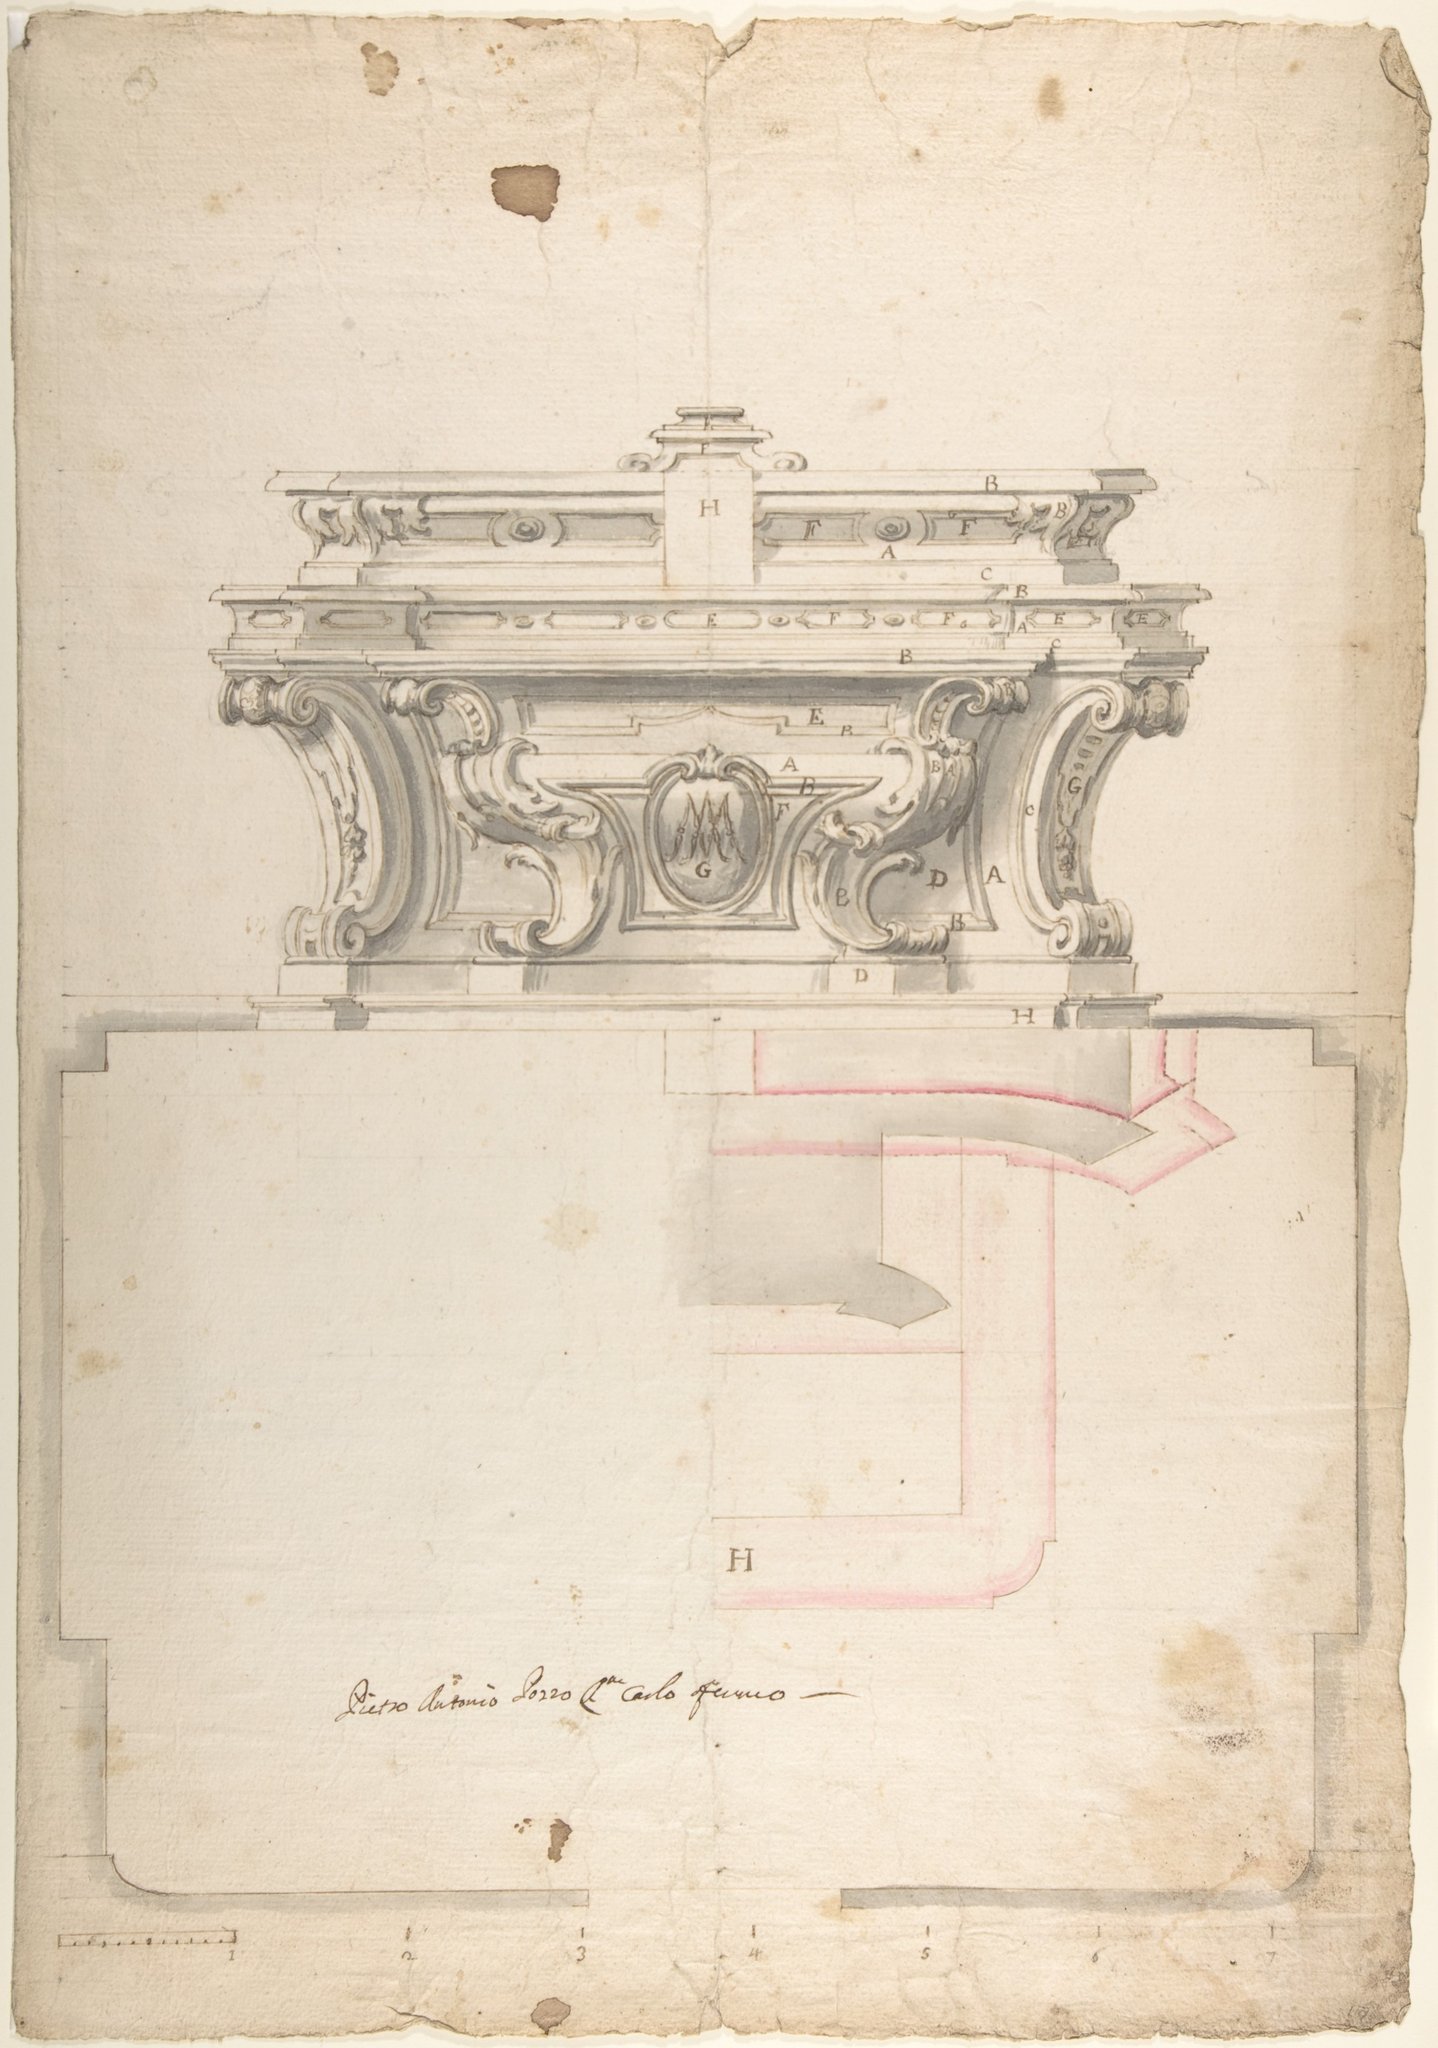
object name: drawing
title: Elevation and Plan for an Altar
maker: anonymous, italian, piedmontese, 18th century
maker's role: artist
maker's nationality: italian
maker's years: 1700-1800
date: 1700-1780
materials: graphite, ink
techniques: brush, drawing, pen, wash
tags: altars